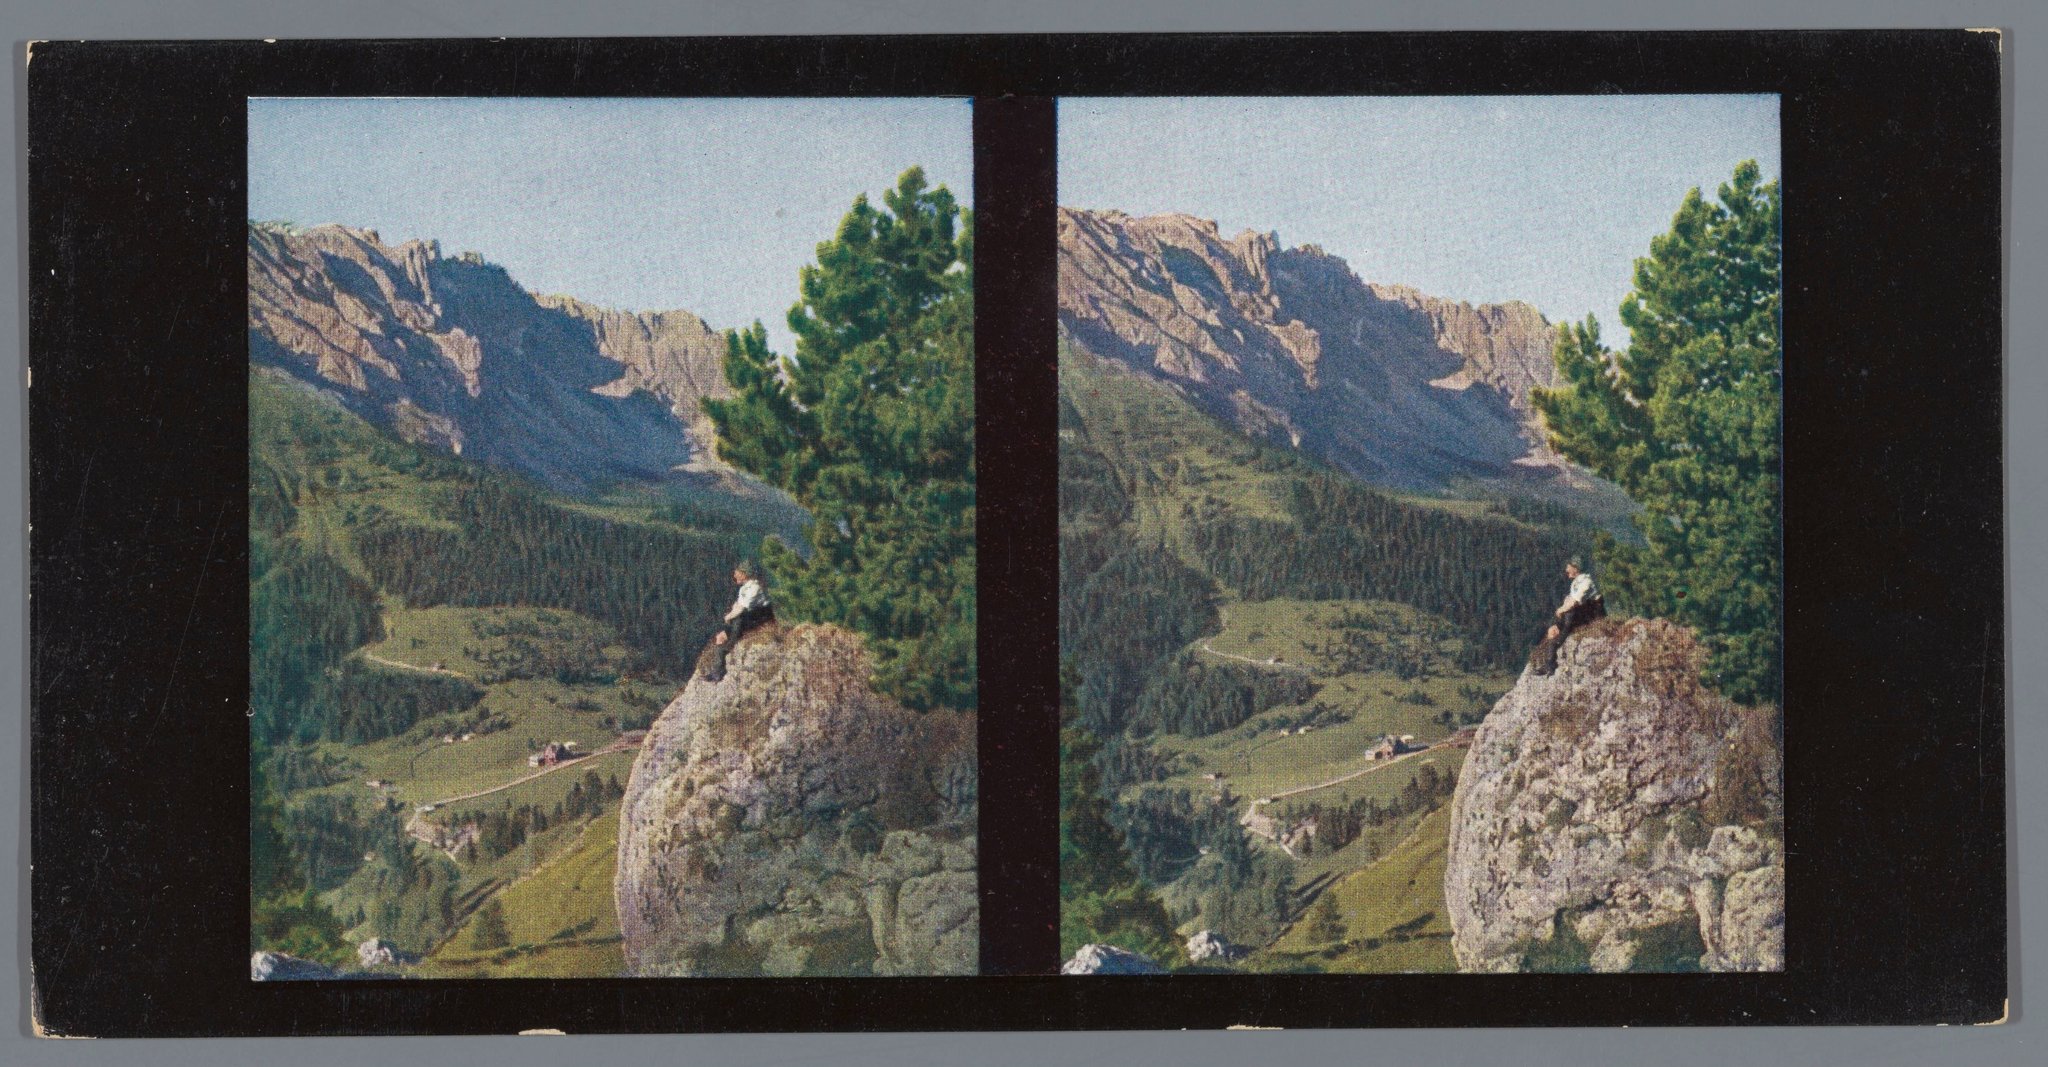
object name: stereograph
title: Karer Pass. Blick zum Latemar.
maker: hans hildenbrand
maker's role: fotograaf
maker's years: 1870-1957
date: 1902-1908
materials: cardboard, ink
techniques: color autotype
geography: dolomites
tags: mountains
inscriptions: number: ‘Nr. 29.’, inscription: ‘,,Chromoplast''-Bild.’, inscription: ‘Beste Wirkung bei Betrachtung durch das ,,Isostereo''.’, inscription: ‘D. R. G. M. Nr. 437 756.’, inscription: ‘Warenzeichen 142 123.’